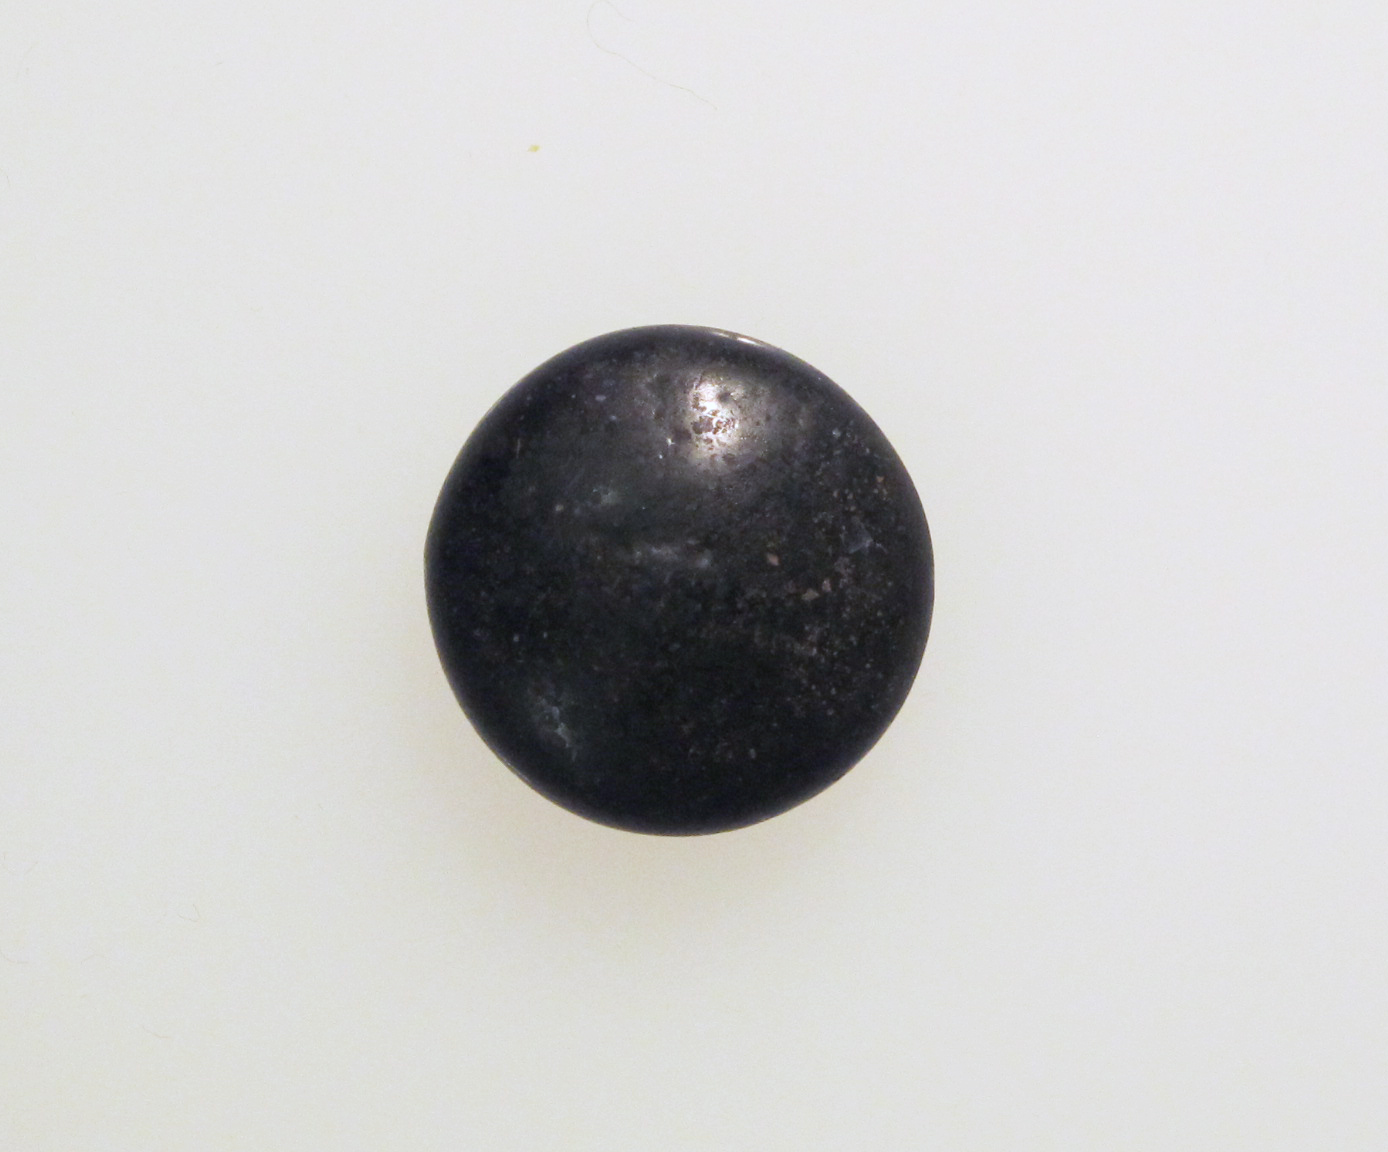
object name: pinhead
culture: roman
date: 100 BCE-500 CE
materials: glass